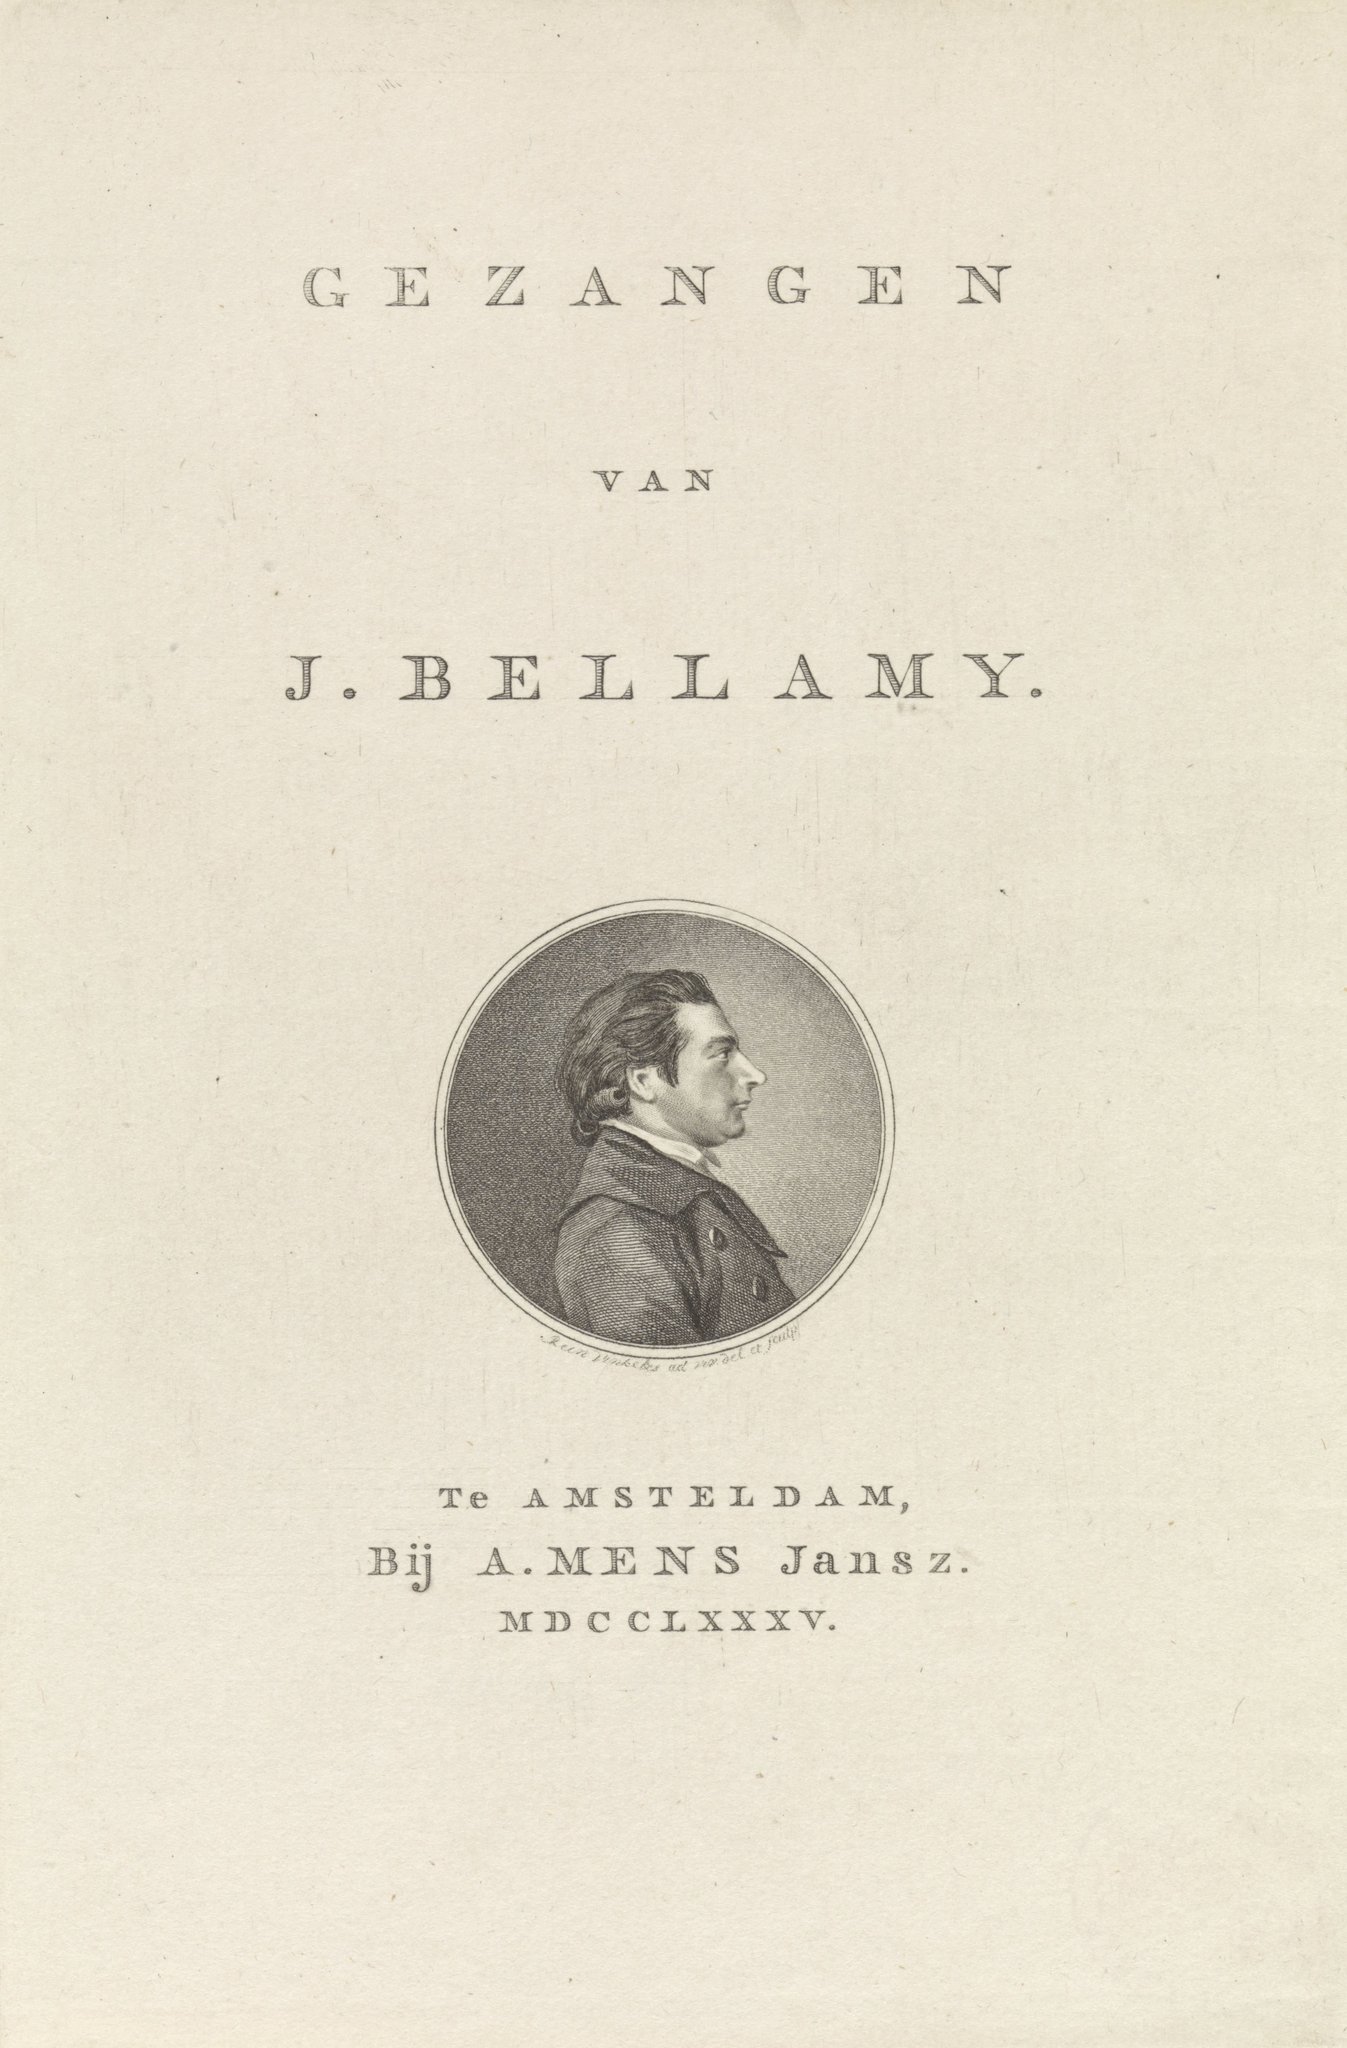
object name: titelblad, titelpagina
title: Titelpagina voor: J. Bellamy, Gezangen, 1785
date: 1785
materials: paper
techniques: etching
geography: amsterdam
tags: flushing, utrecht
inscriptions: collector's mark: Lugt 240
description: Titelpagina voor: Bellamy, Jacobus. Gezangen. Amsterdam: Anthony Mens Jansz., 1785.